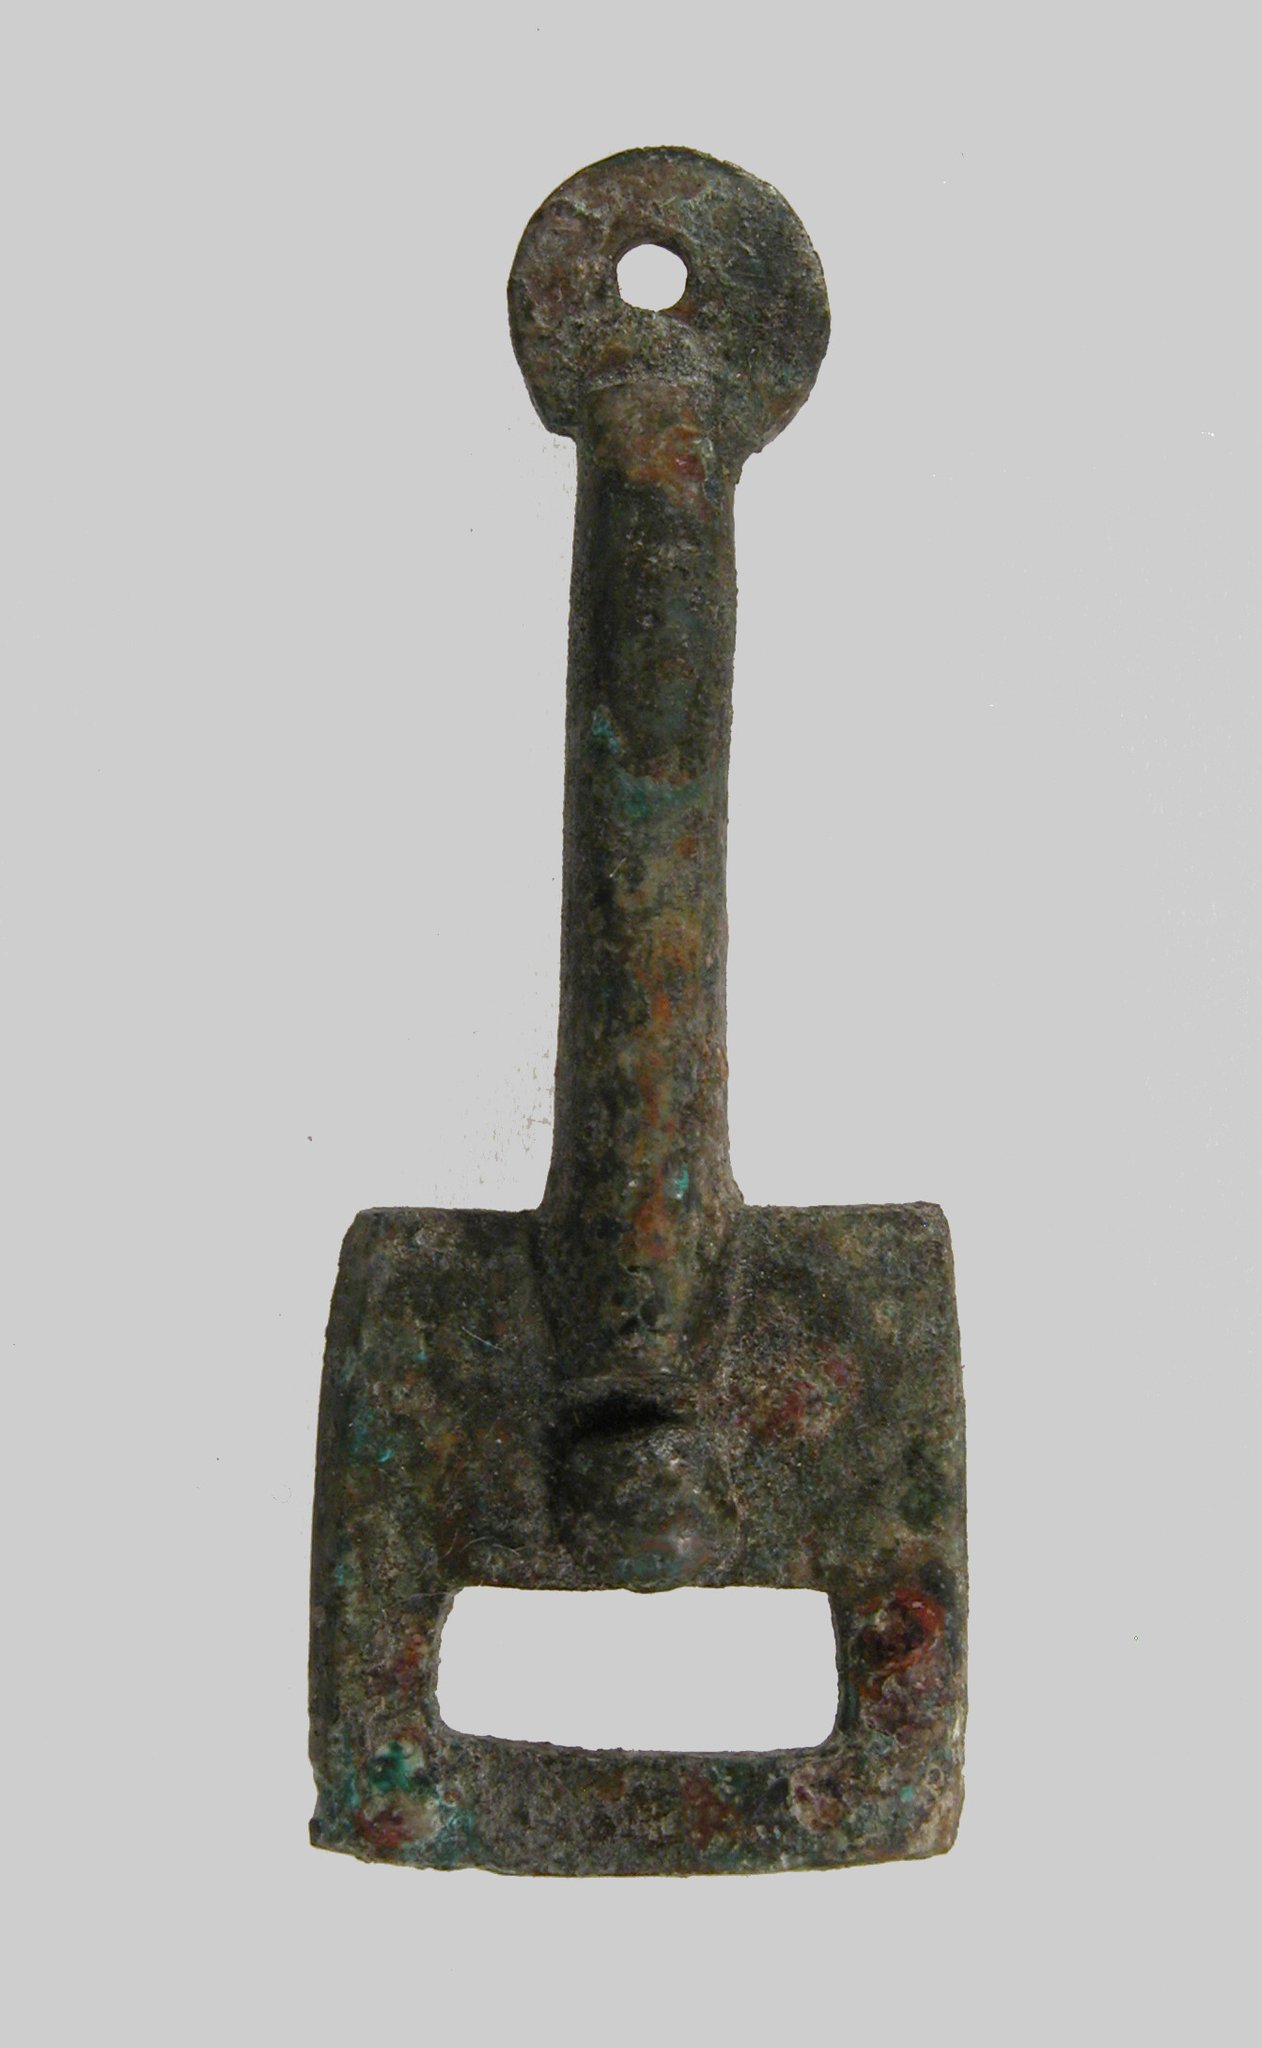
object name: plaque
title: Rectangular Plaque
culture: frankish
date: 534-566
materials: copper alloy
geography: rhein